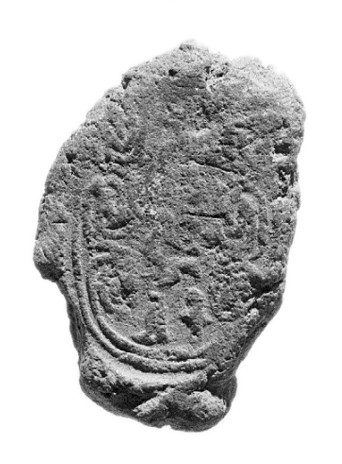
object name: sealing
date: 1981-1640 BCE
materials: mud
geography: egypt